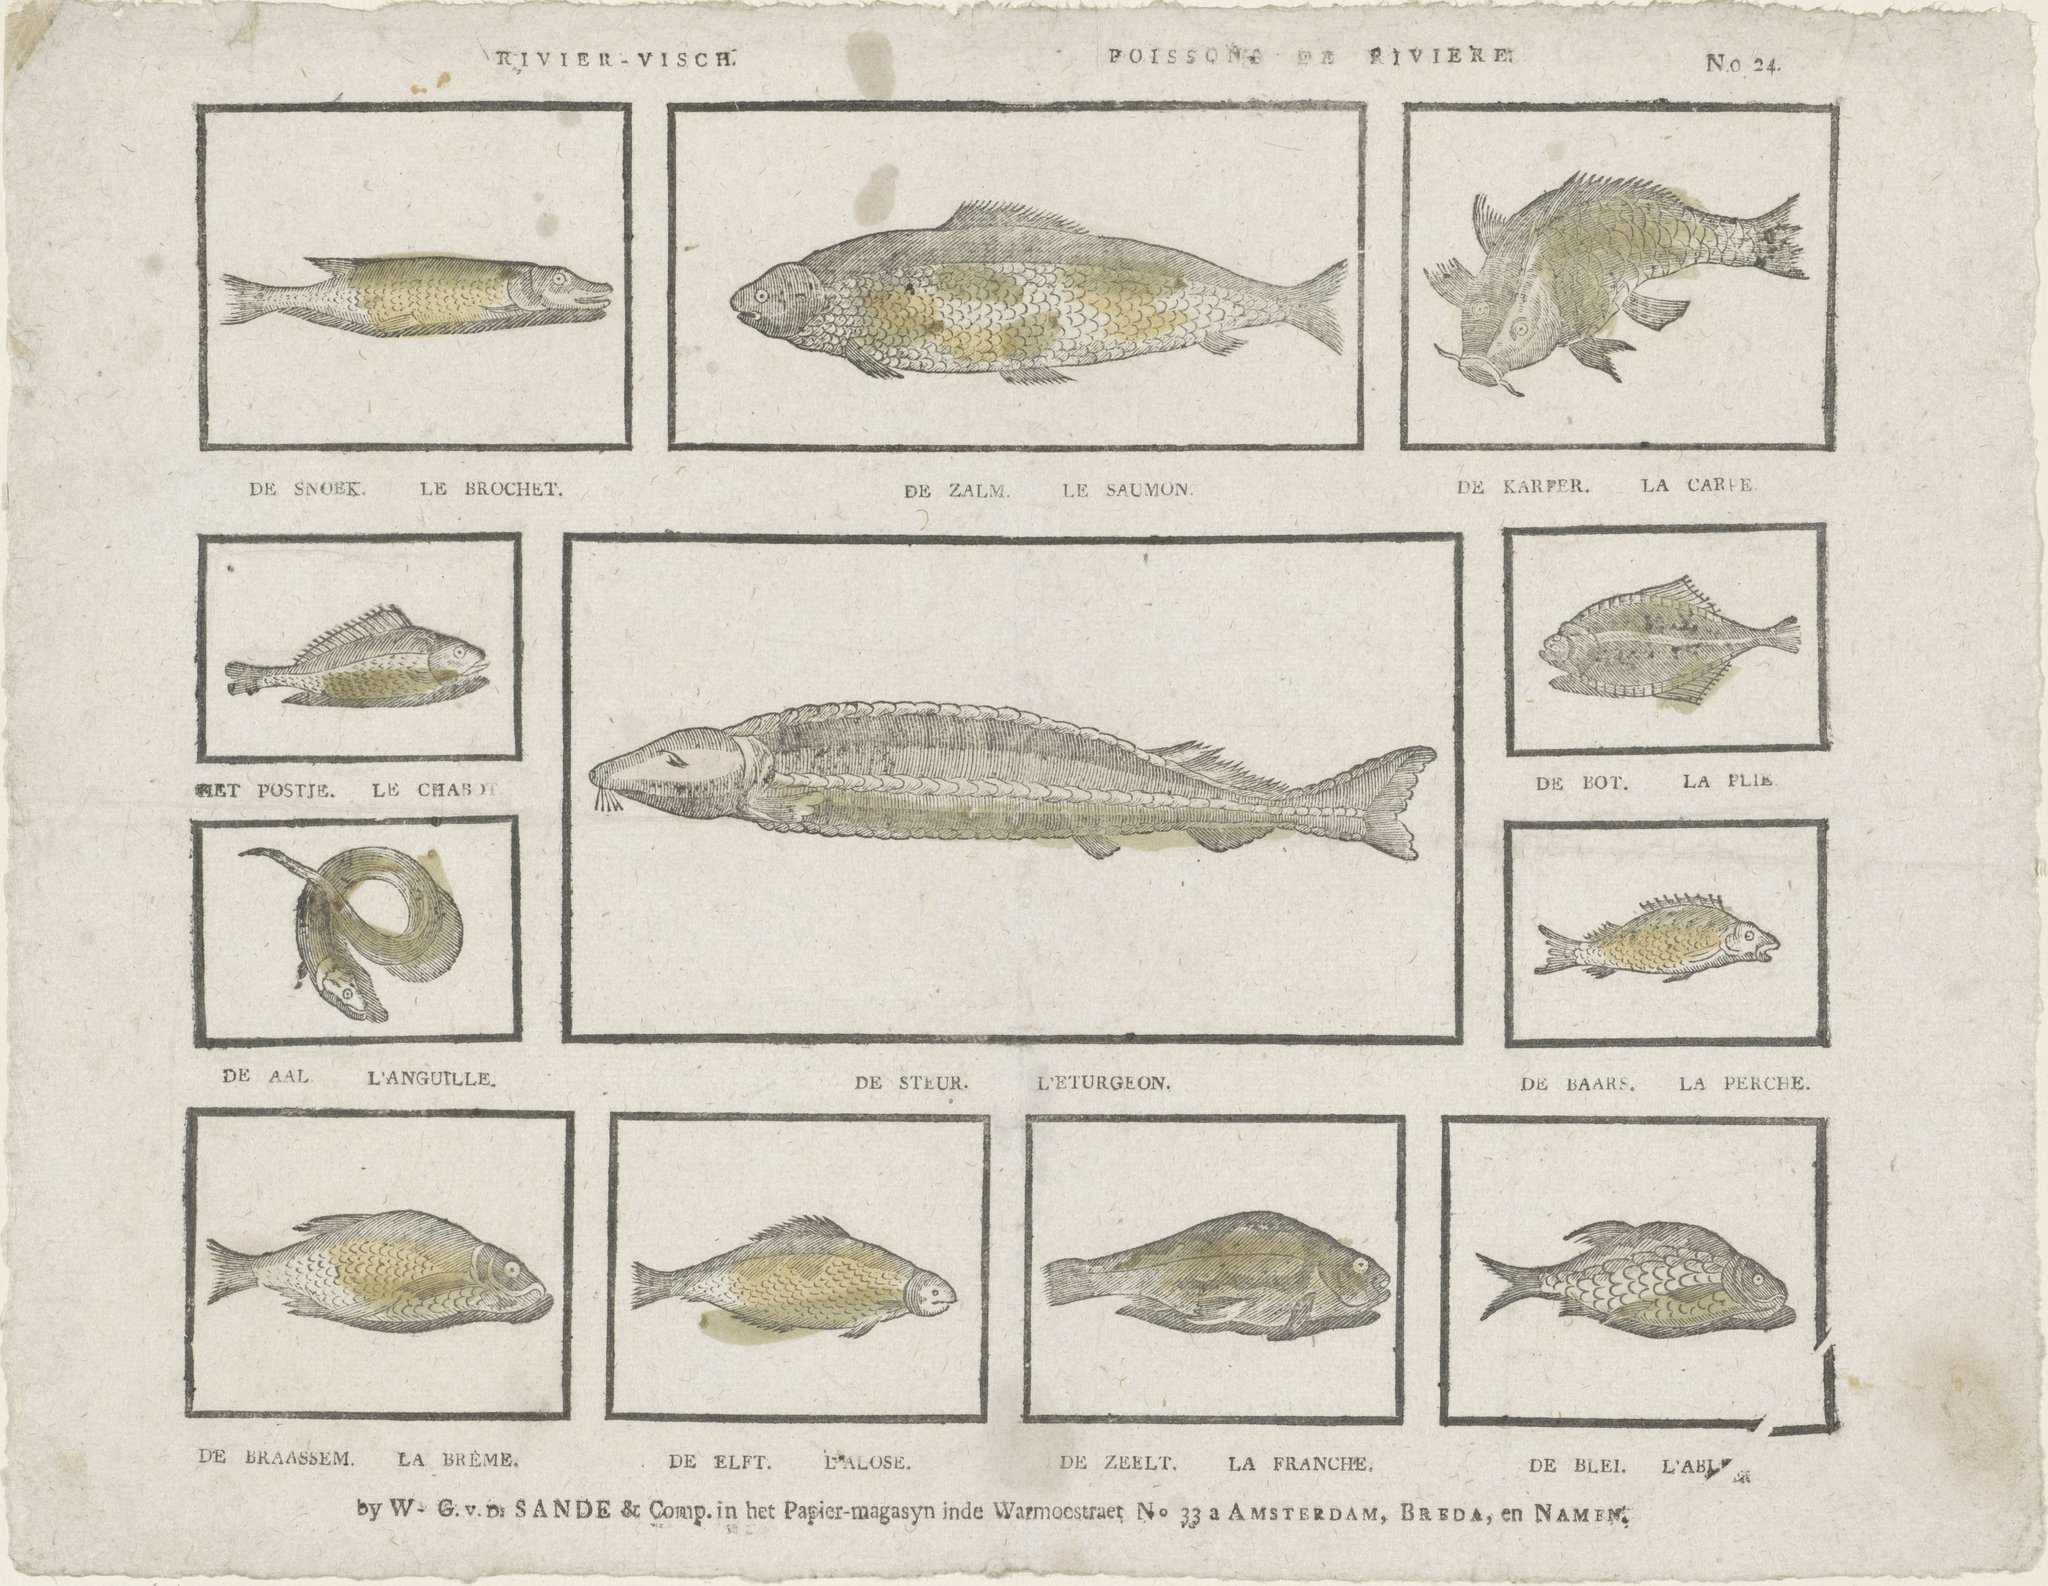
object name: print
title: Rivier-visch / Poisson de riviere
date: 1806-1814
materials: paper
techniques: colour, letterpress printing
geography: europe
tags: fishes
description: Blad 12 voorstellingen van riviervissen, zoals een zalm, een karper, een steur en een baars. Onder elke voorstelling de naam van de vis in het Nederlands en in het Frans. Genummerd rechtsboven: No. 24.